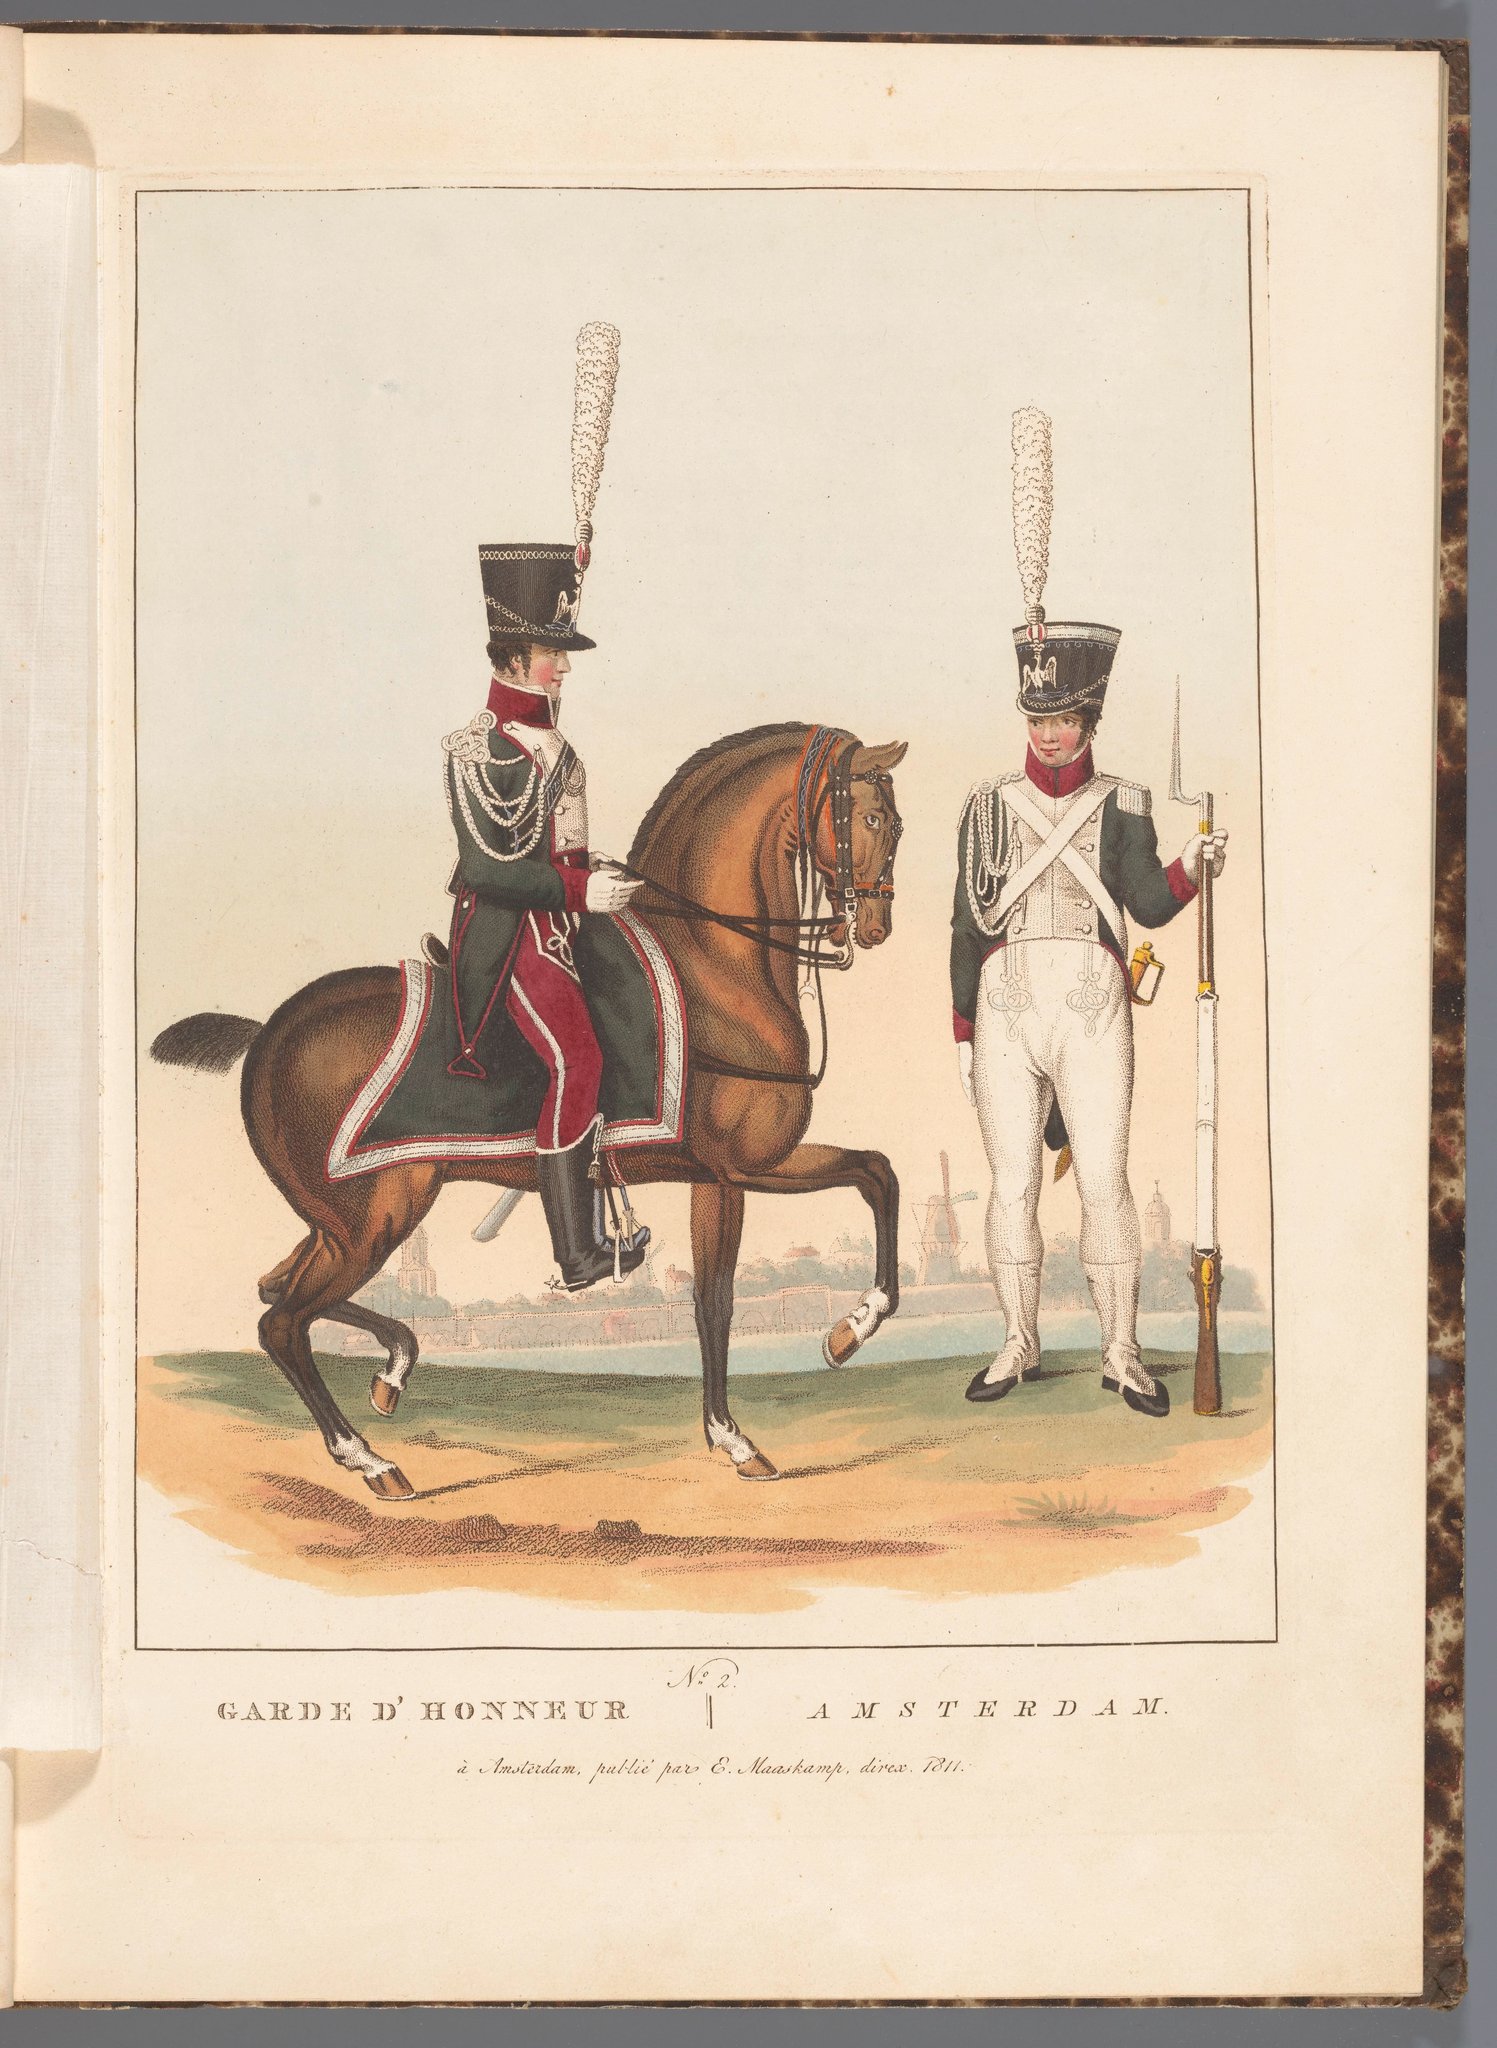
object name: print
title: No. 2 Garde d'Honneur / Amsterdam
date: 1811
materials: paper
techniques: etching, hand coloring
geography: amsterdam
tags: napoleon i (emperor of the french), guard of honour, (military) uniforms, amsterdam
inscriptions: date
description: Twee leden van de cavalerie en de infanterie van de erewacht te Amsterdam. Onderdeel van het plaatwerk met twaalf platen van de verschillende uniformen van de erewachten in de zeven Nederlandse departementen, opgericht voor het bezoek van Napoleon Bonaparte aan Nederland in 1811.